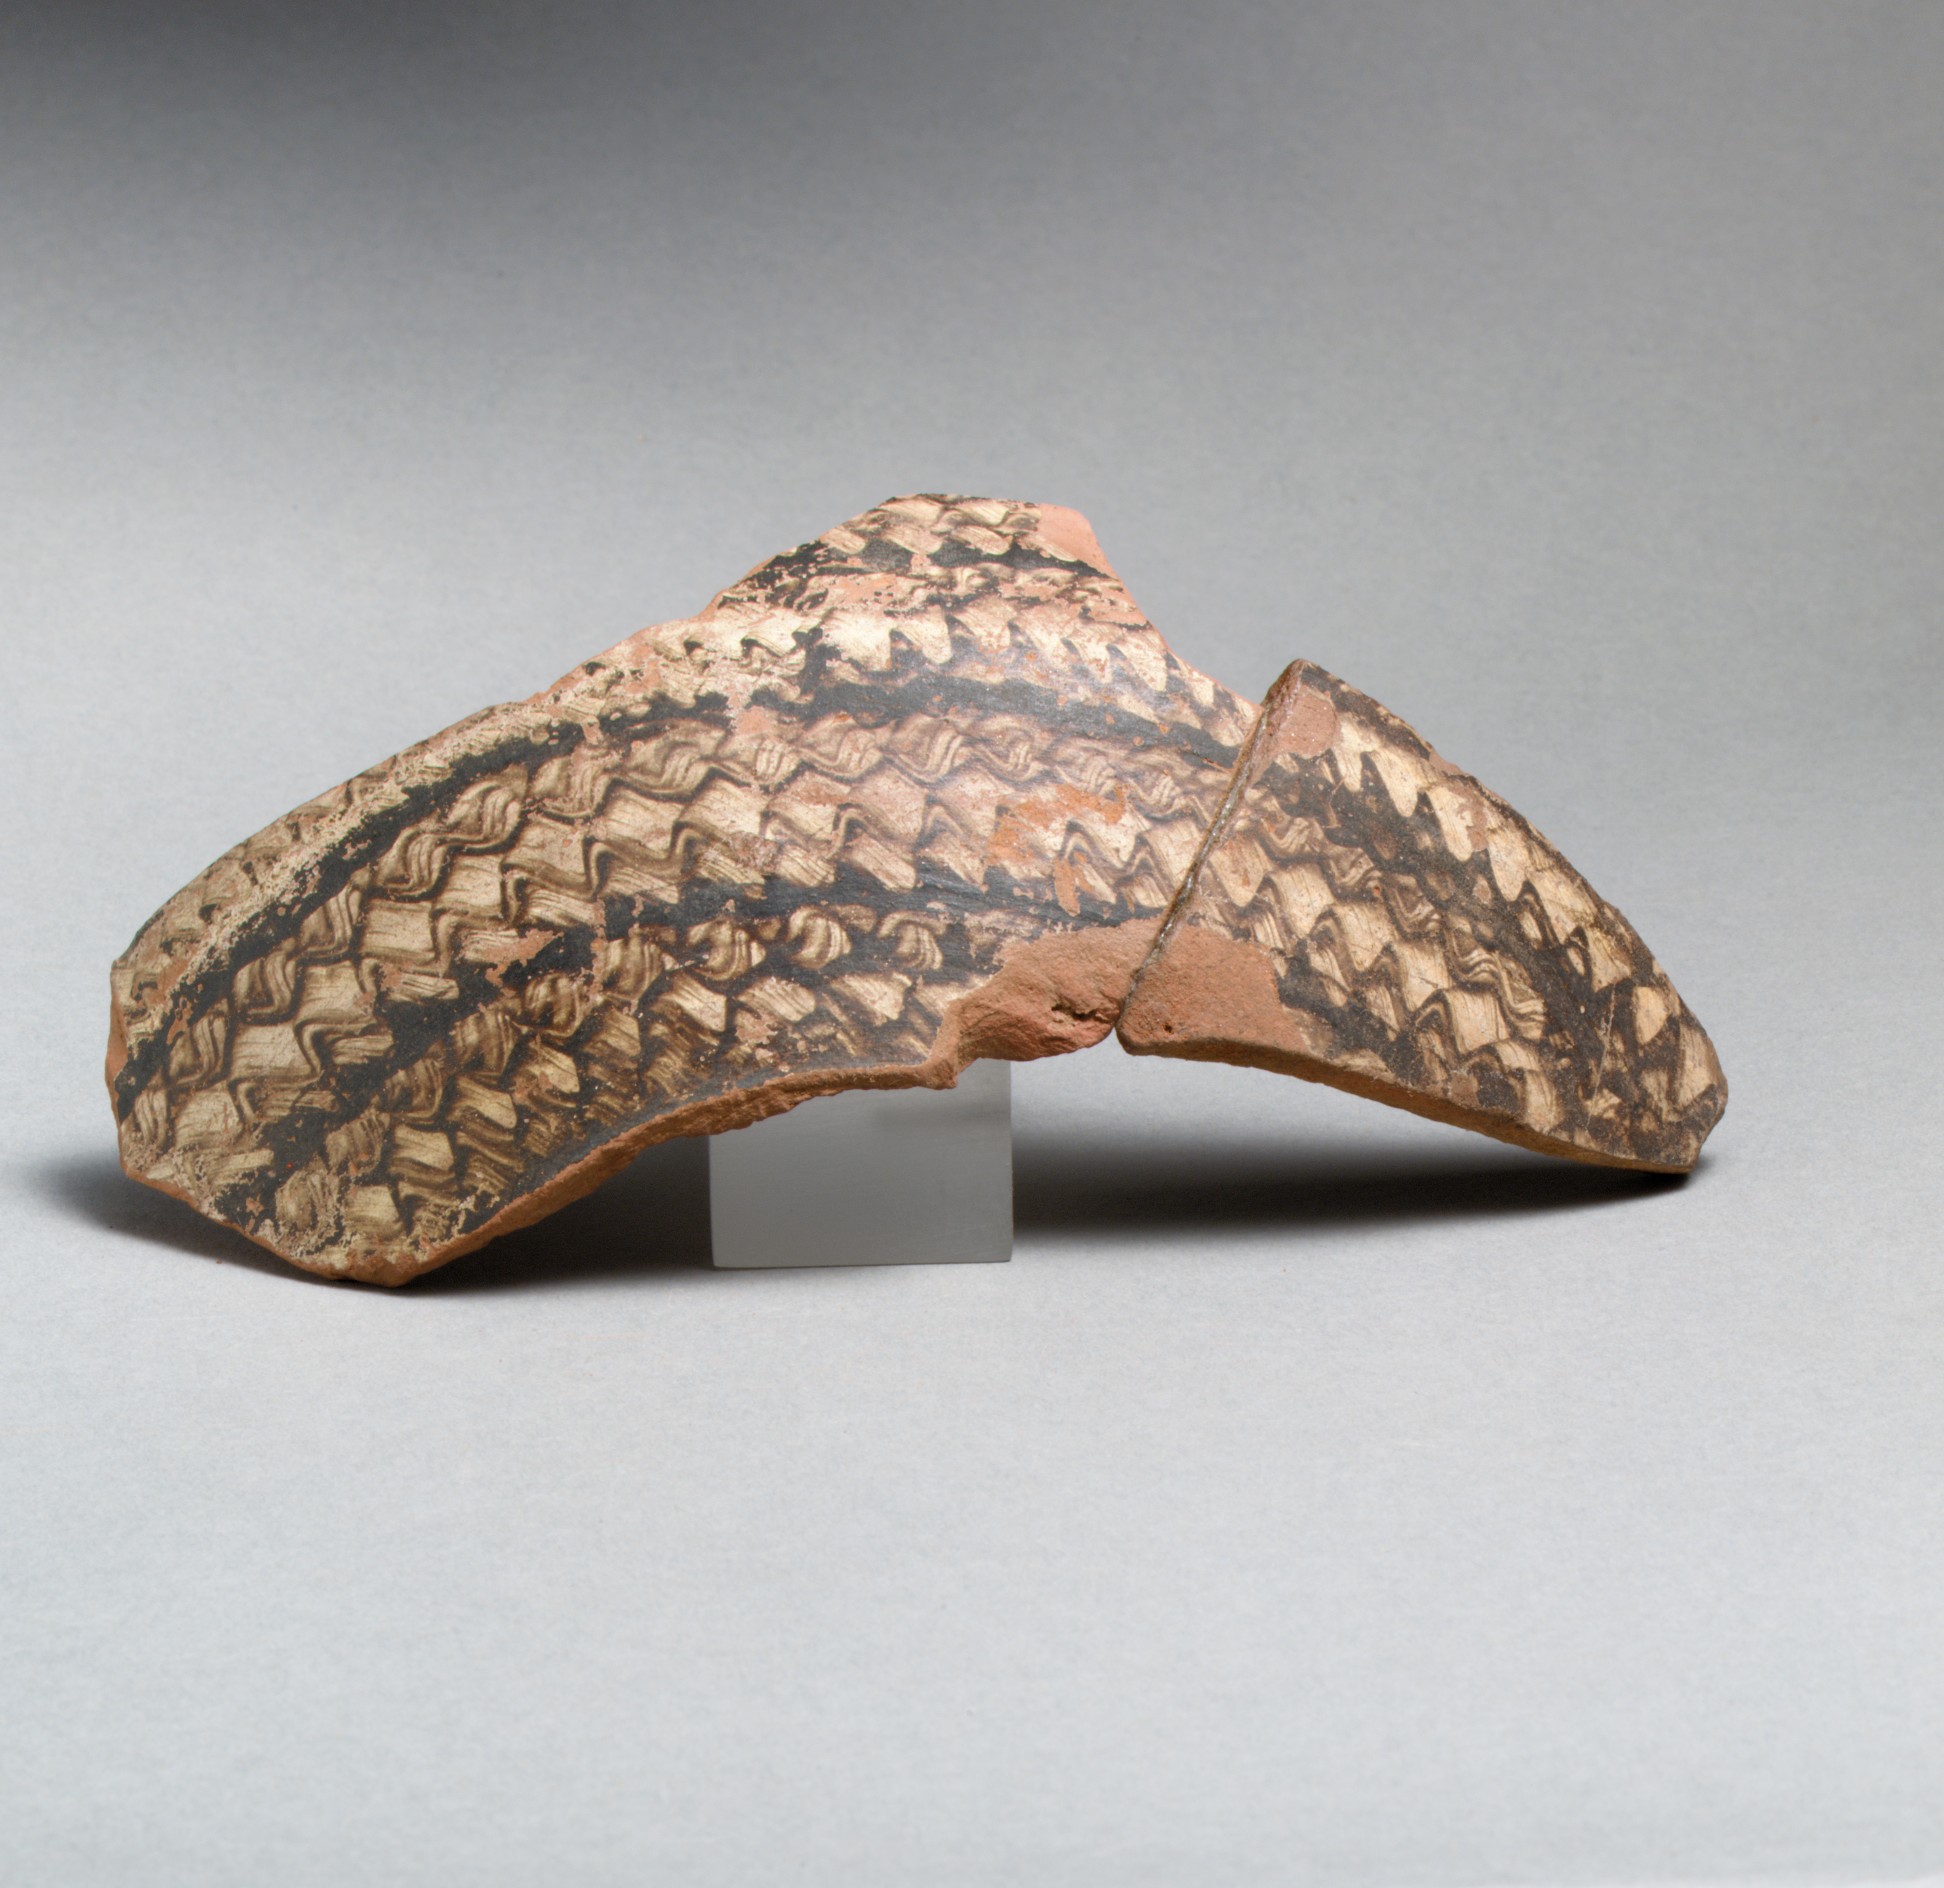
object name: vase fragment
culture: greek or lydian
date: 900-30 BCE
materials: terracotta